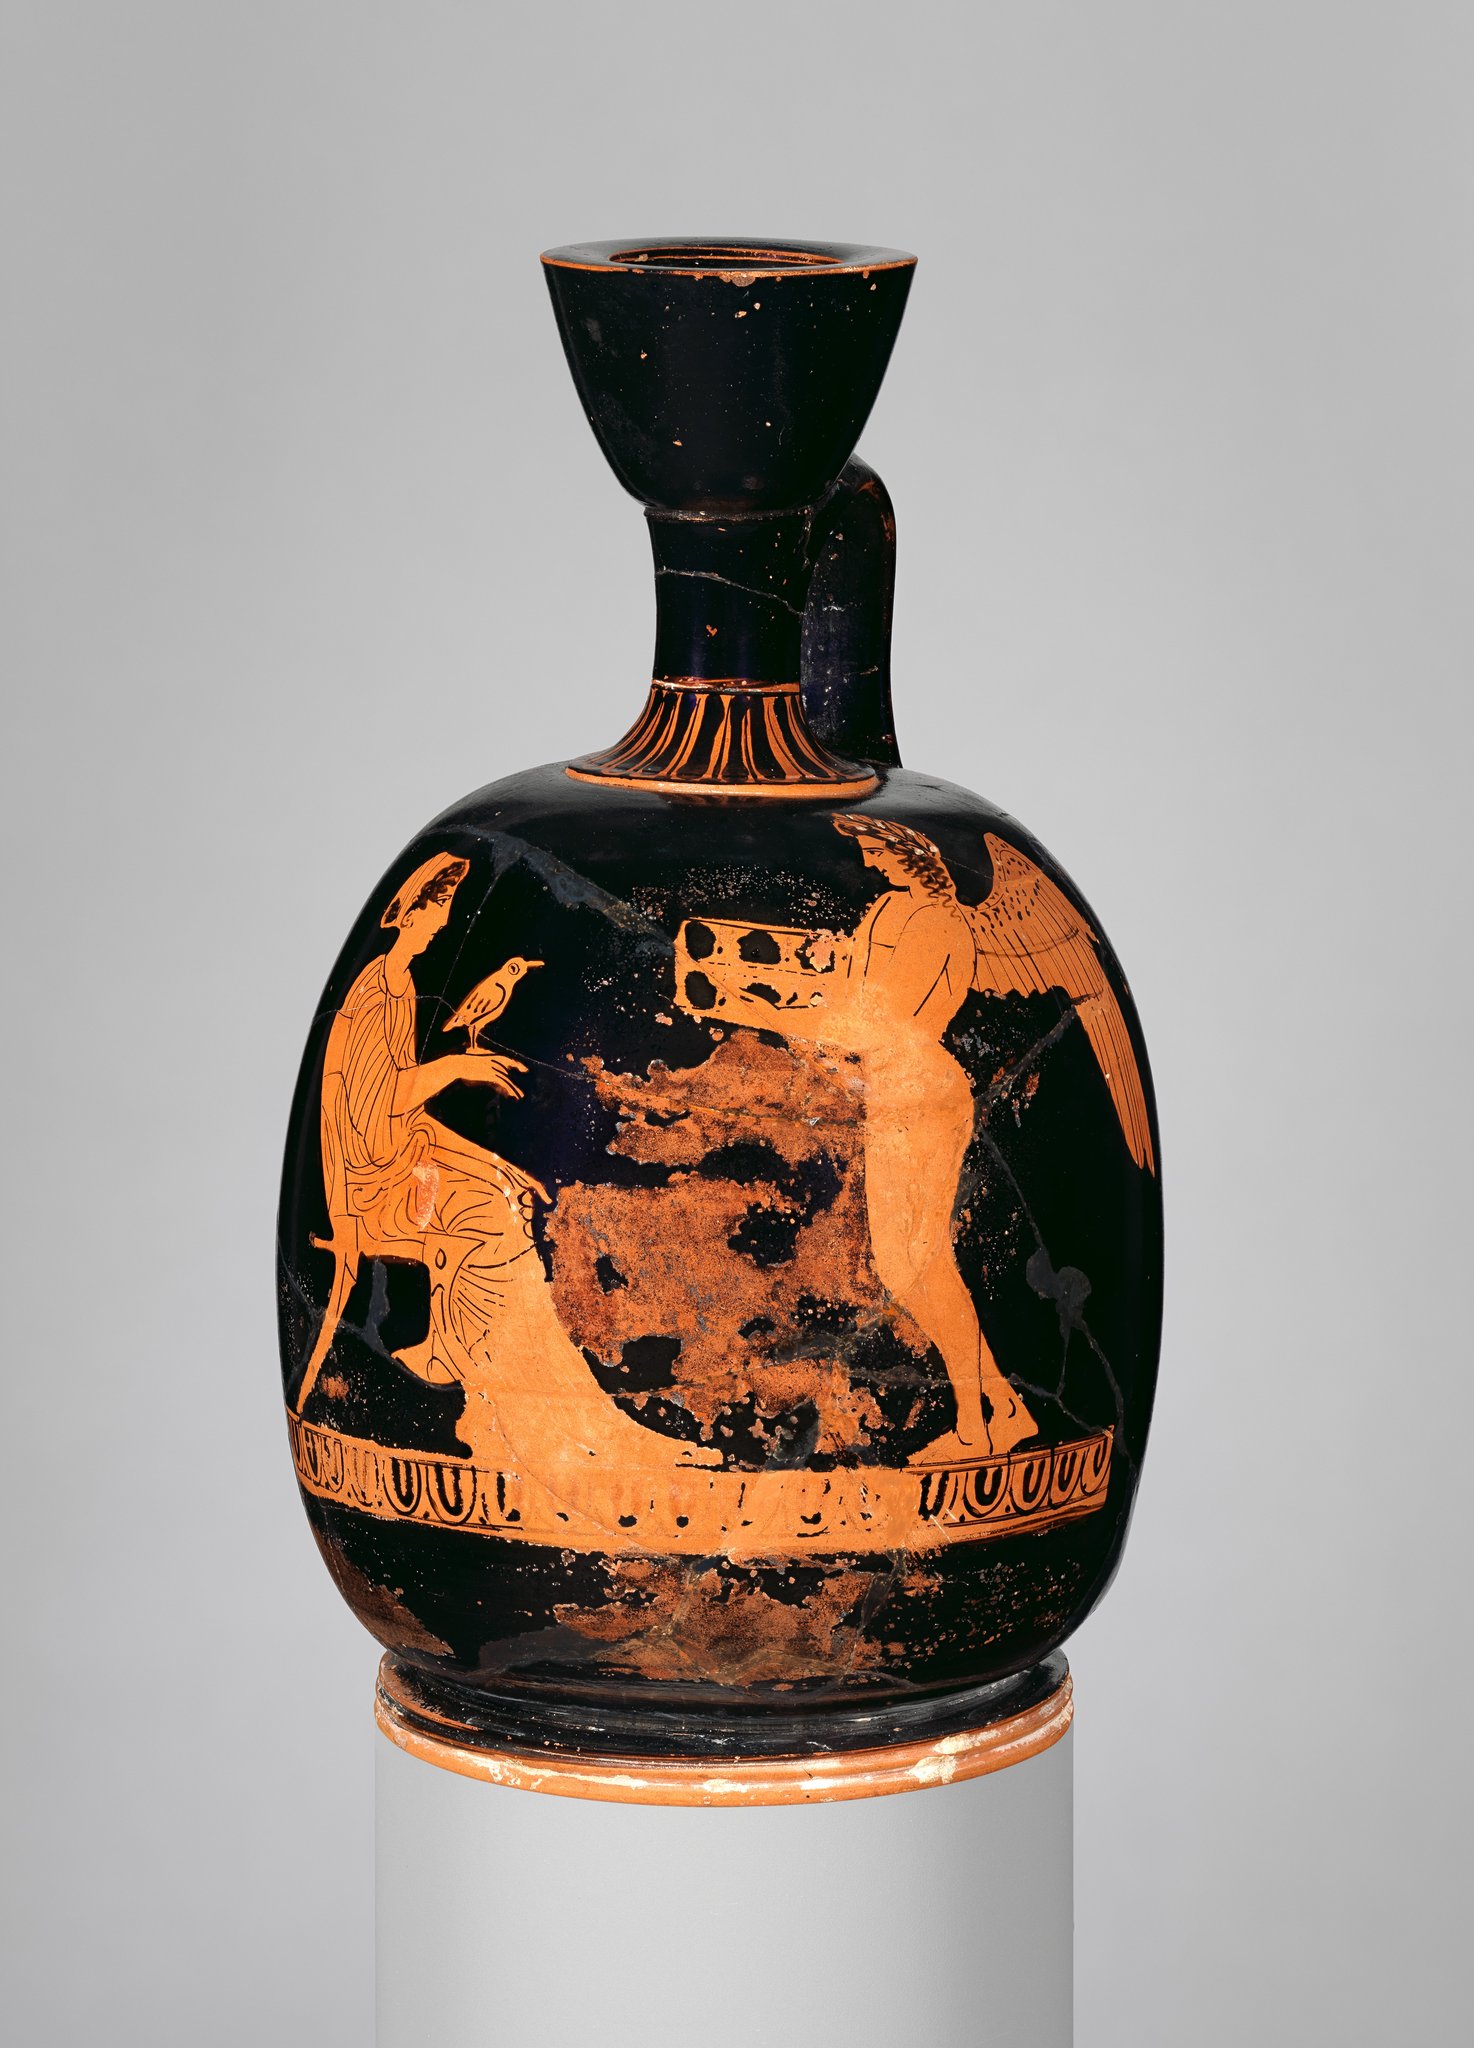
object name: squat lekythos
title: Terracotta squat lekythos (oil flask)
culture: greek, attic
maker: washing painter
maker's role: artist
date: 420 BCE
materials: terracotta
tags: birds,women,eros